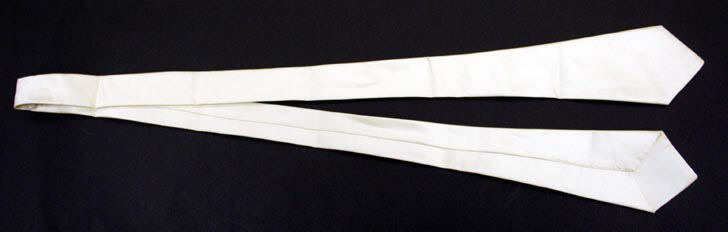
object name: necktie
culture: american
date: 1869